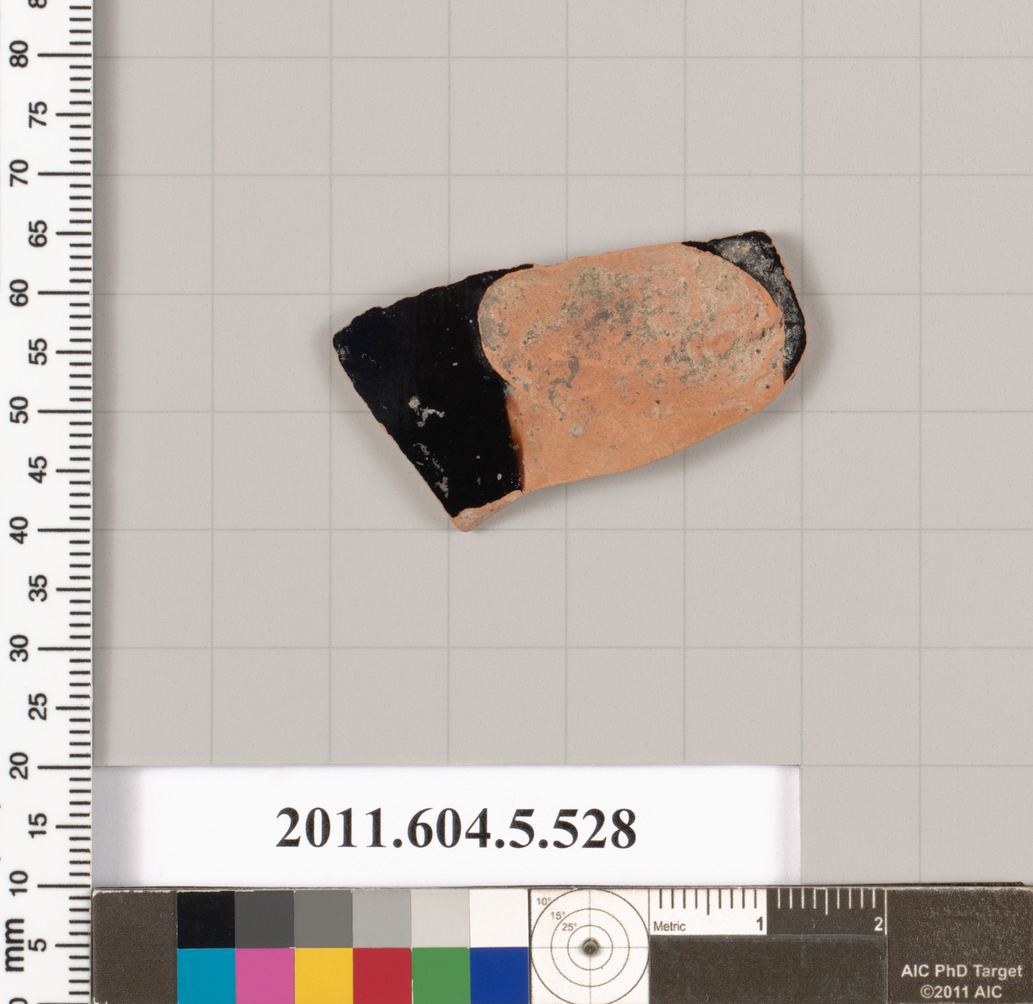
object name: kylix fragment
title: Terracotta fragment of a kylix (drinking cup)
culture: greek, attic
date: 600-401 BCE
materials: terracotta